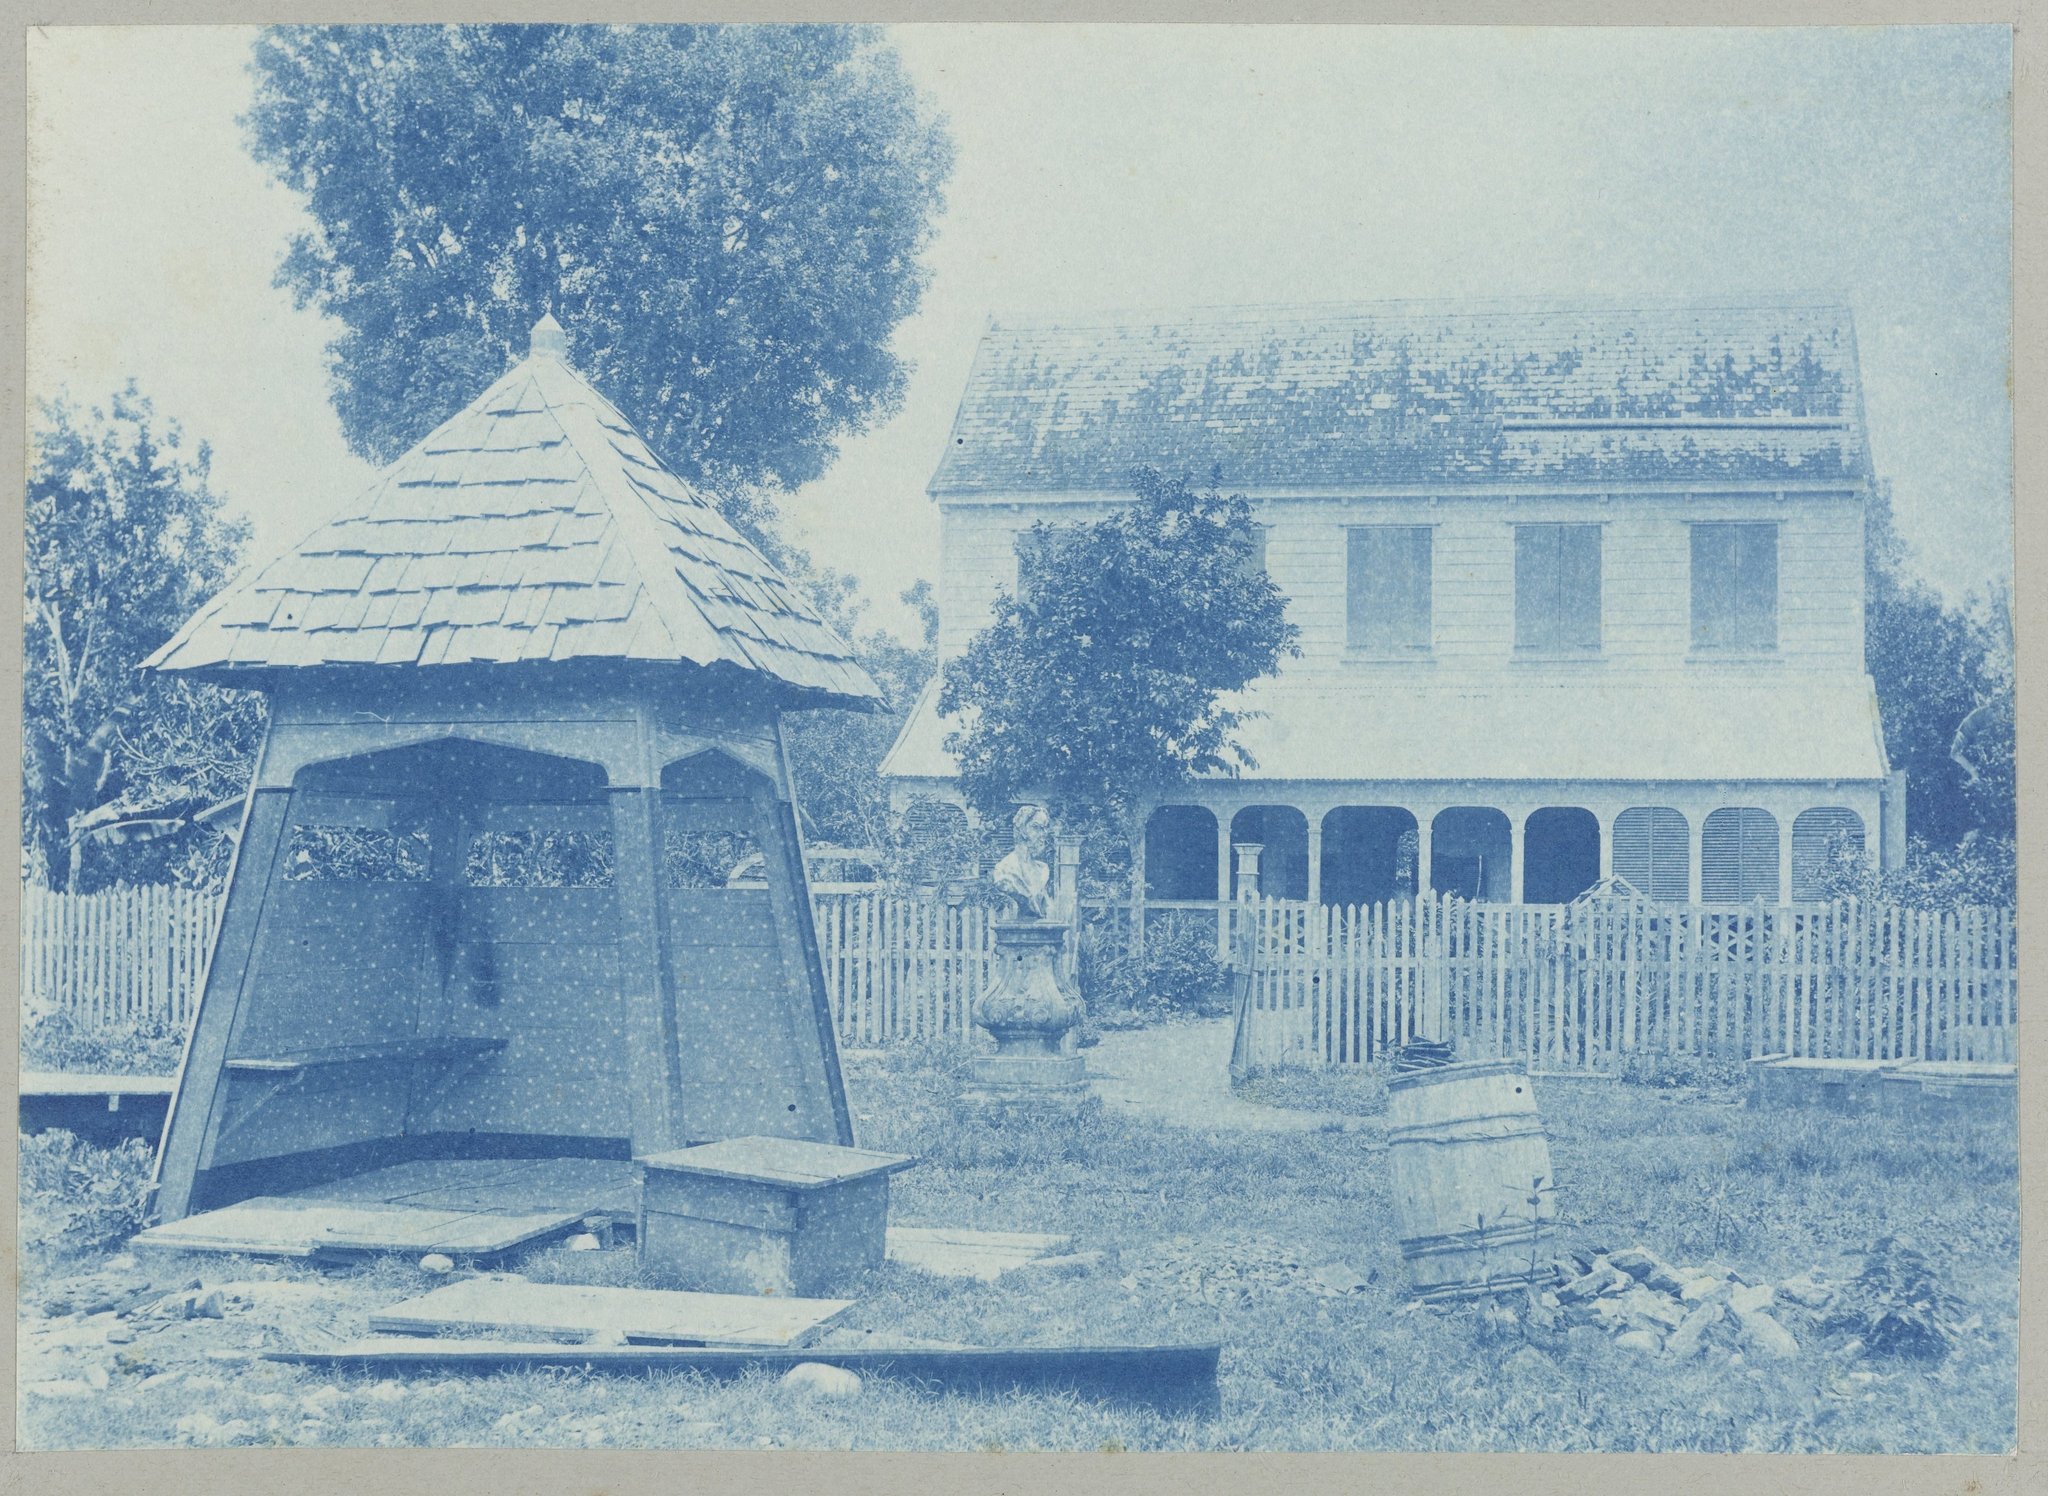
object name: photograph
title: Plantagehuis op "Ma retraite"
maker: hendrik doijer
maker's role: engineer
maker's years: 1863-1925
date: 1903-1910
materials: photographic support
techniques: cyanotype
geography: suriname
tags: suriname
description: Het plantagehuis op de plantage Ma Retraite. Buiten het hek in de tuin een soort theehuisje, een borstbeeld op een voetstuk en rondslingerende rommel. Onderdeel van het fotoalbum Souvenir de Voyage (deel 1), over het leven van de familie Doijer in en rond de plantage Ma Retraite in Suriname in de jaren 1903-1910.